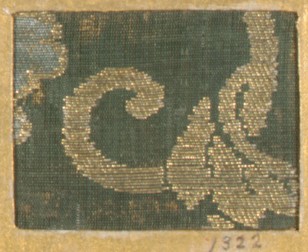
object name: piece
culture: japanese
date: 1701-1900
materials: silk